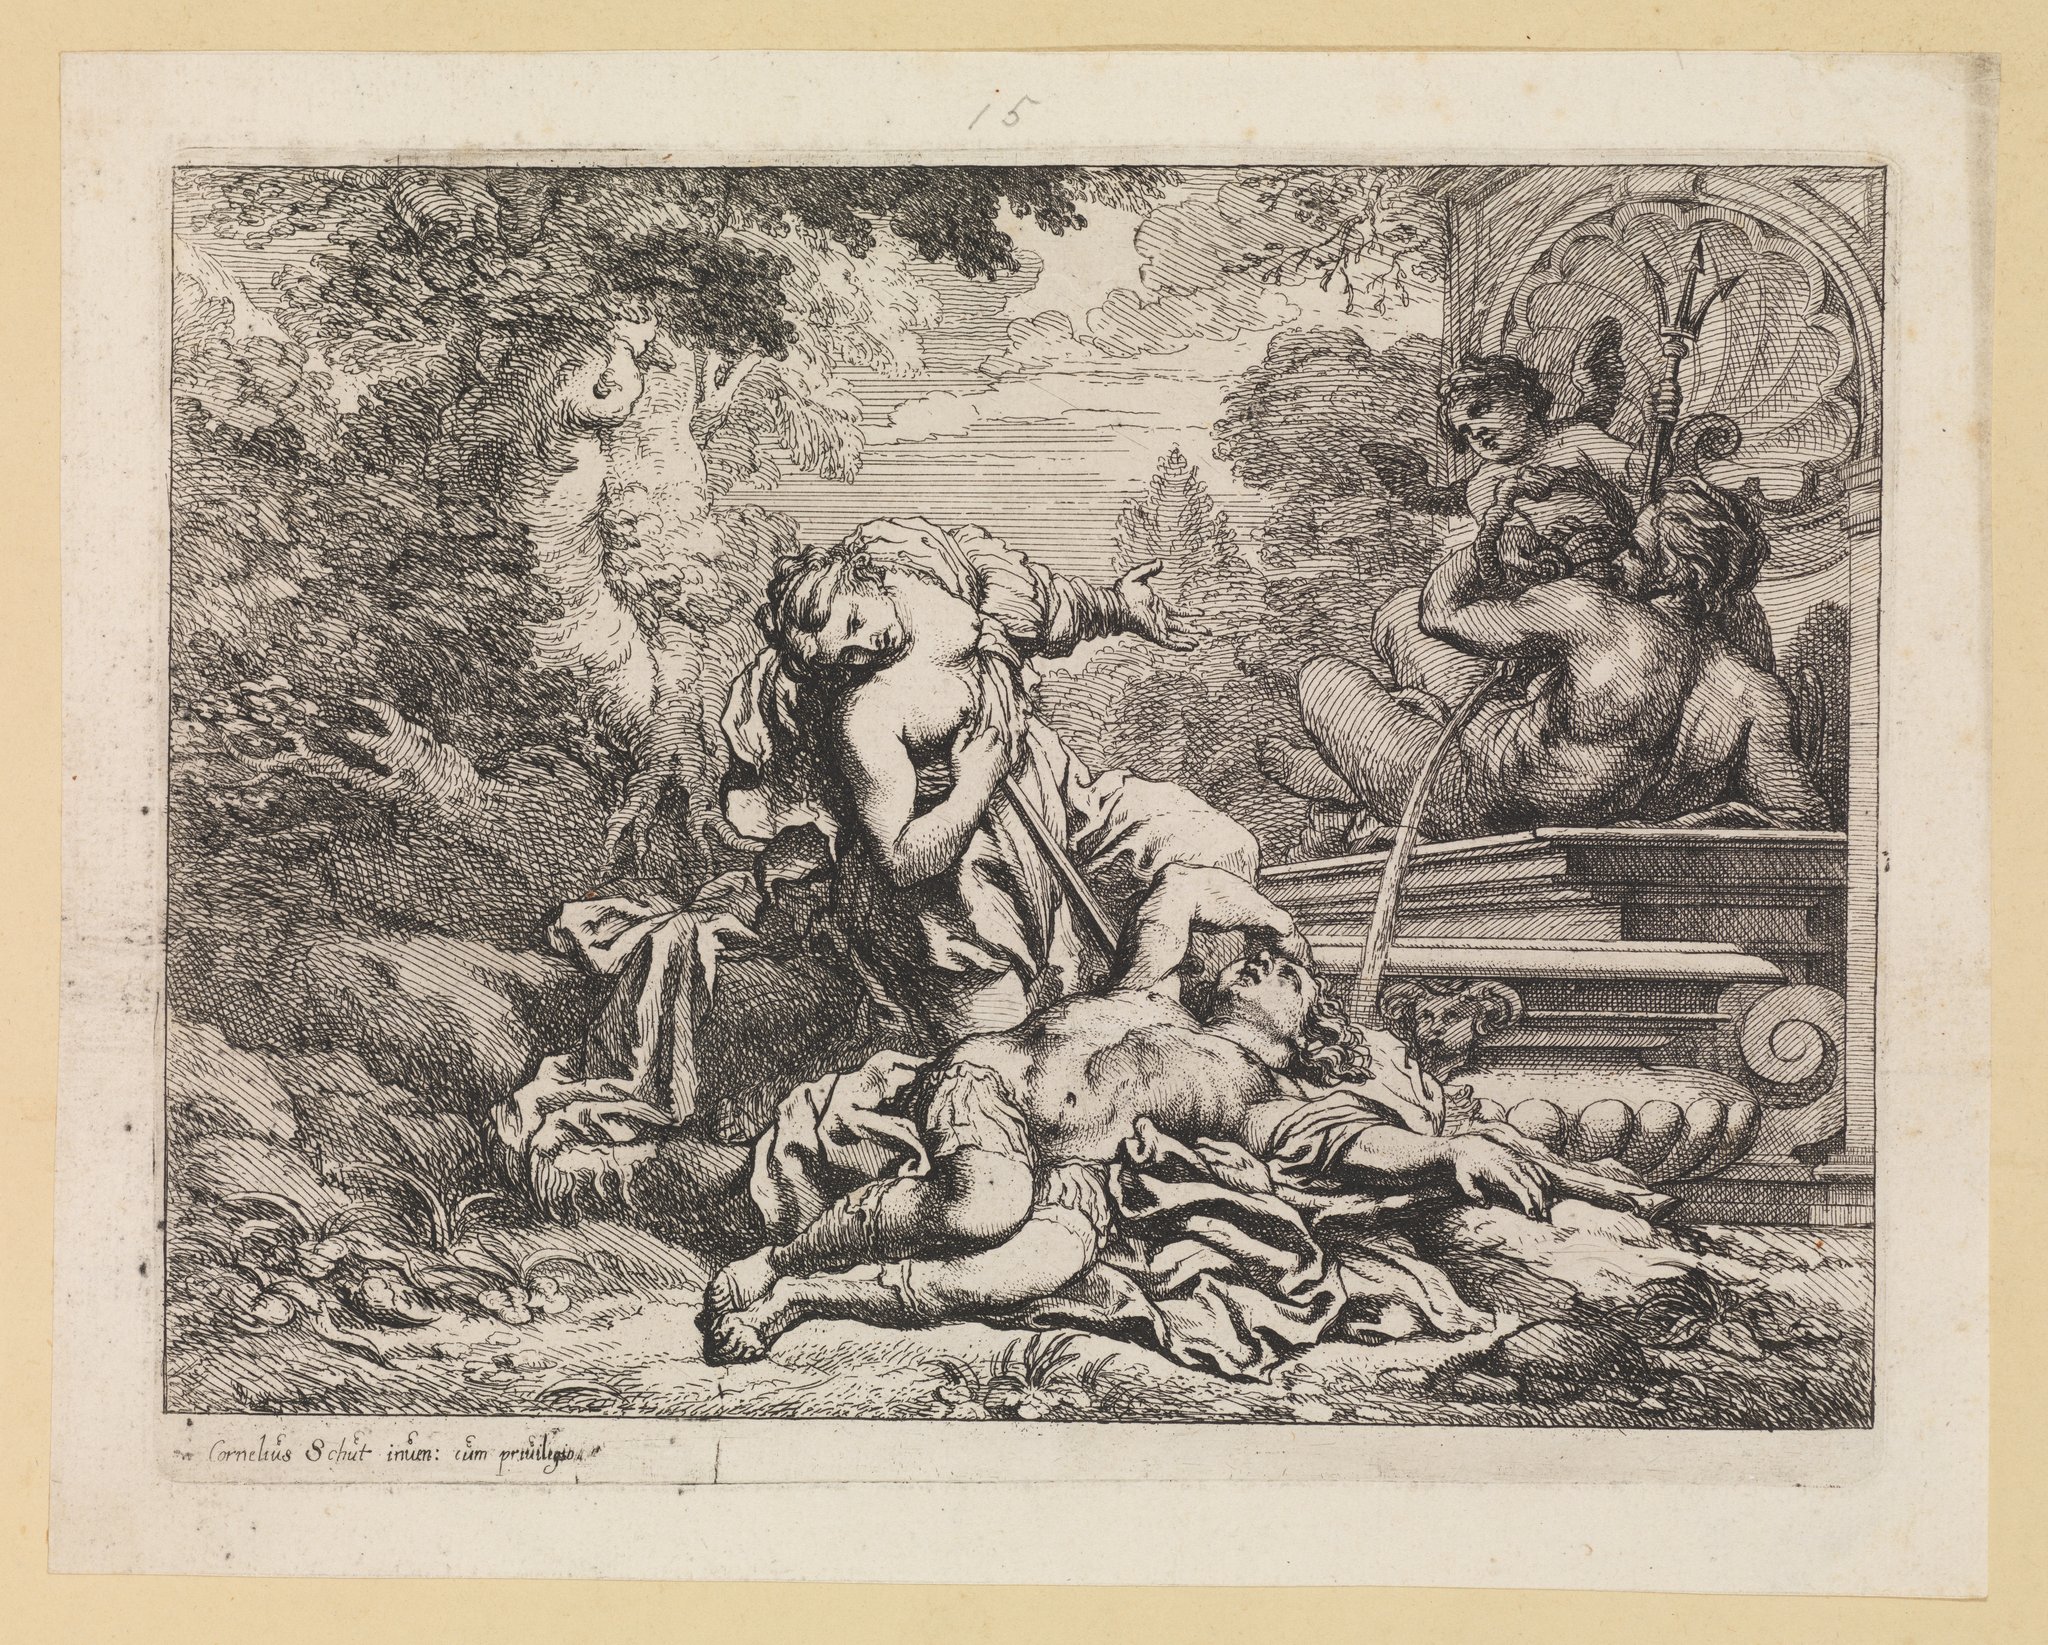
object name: print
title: Pyramus and Thisbe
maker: cornelis schut (i)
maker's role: artist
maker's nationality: flemish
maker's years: 1597-1655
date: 1601-1700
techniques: etching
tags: male nudes,female nudes